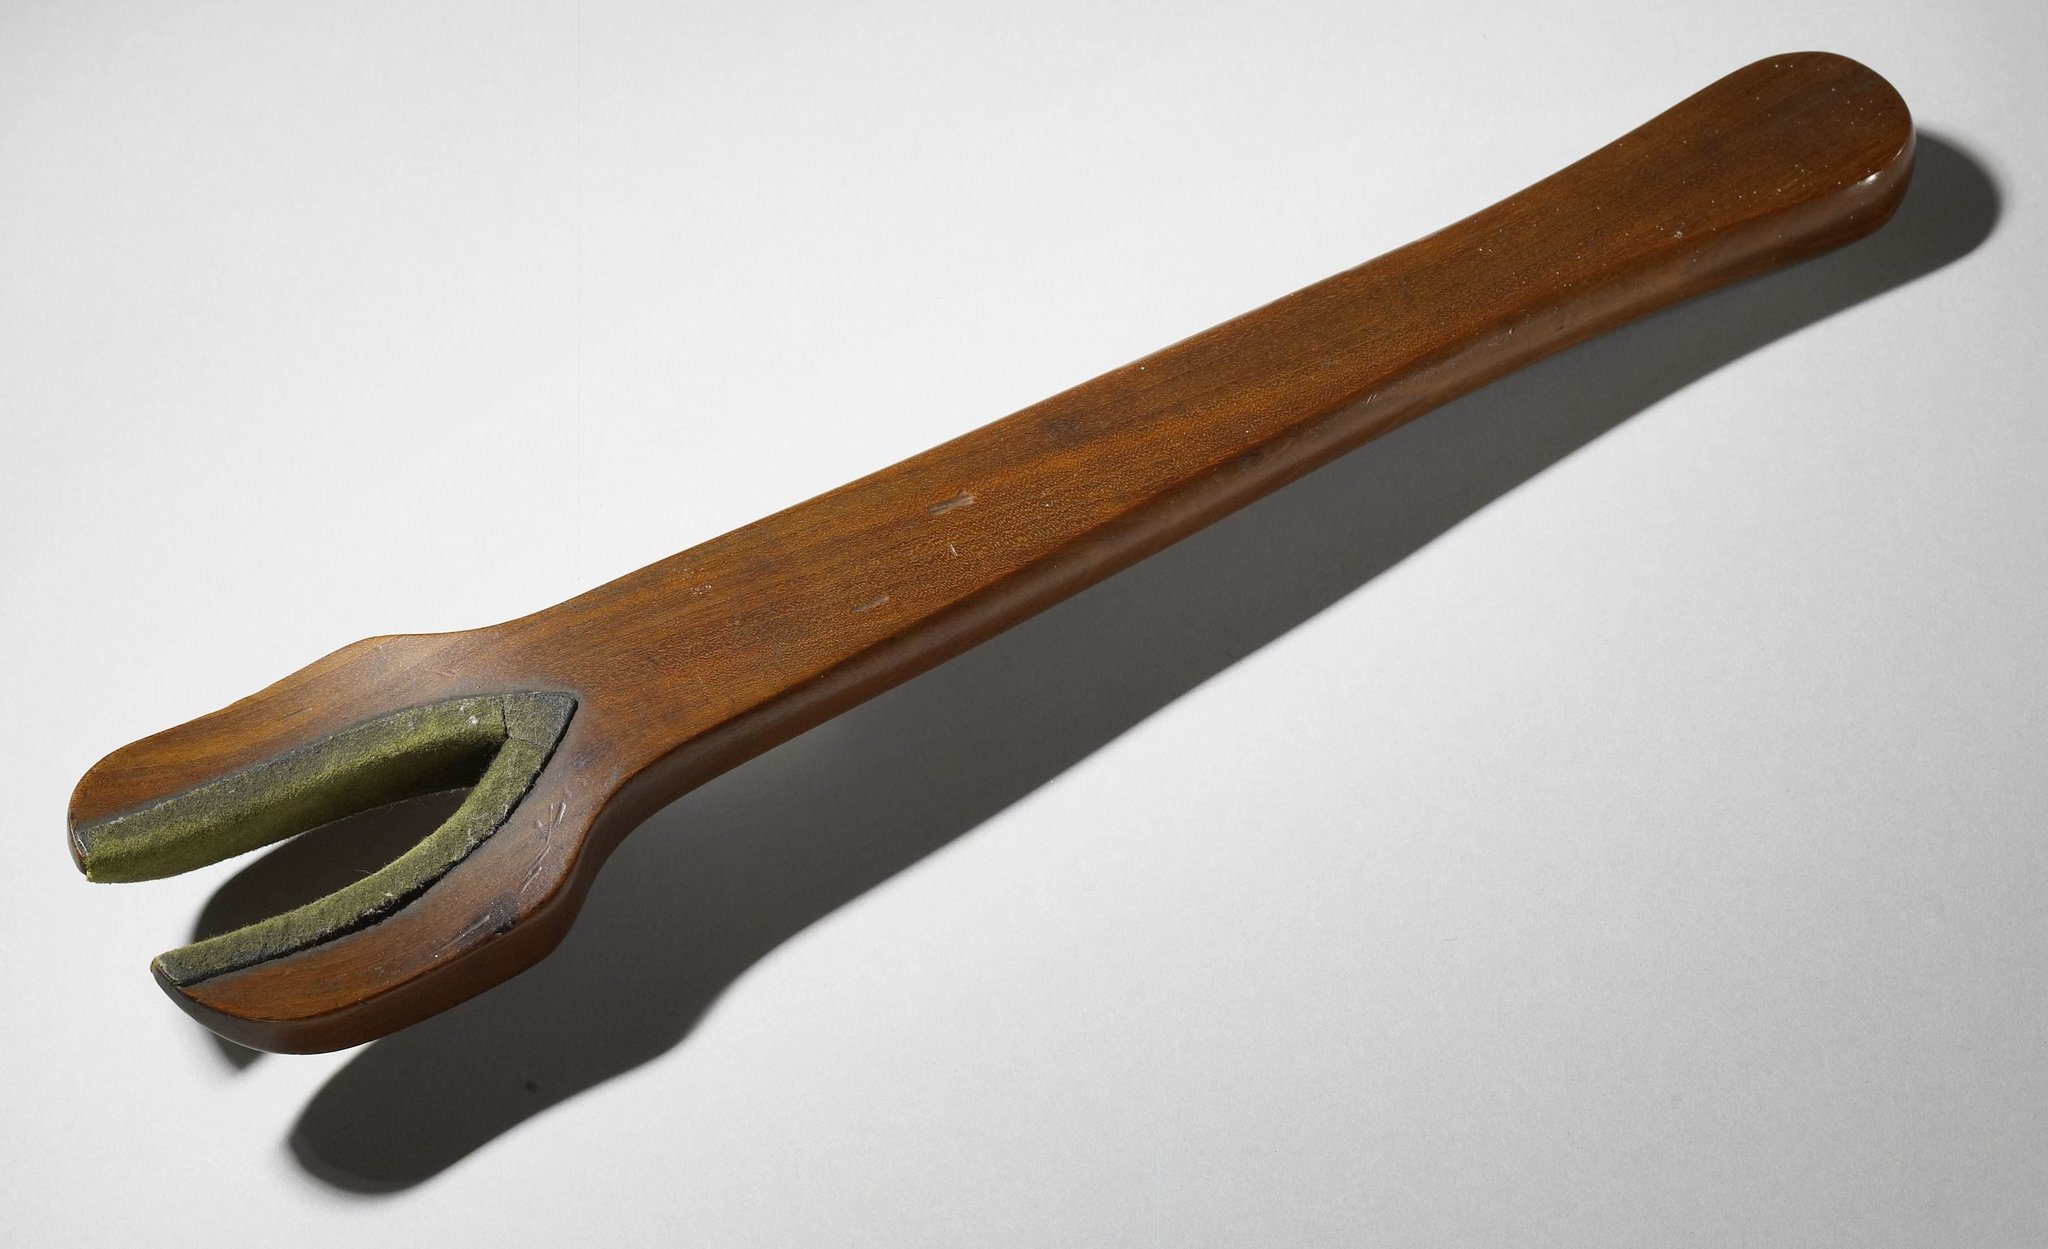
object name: weight scale component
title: Gewichtenvork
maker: Anonymous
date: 1850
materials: wood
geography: netherlands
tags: netherlands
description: Houten gewichtenvork, plaatselijk bekleed met laken.